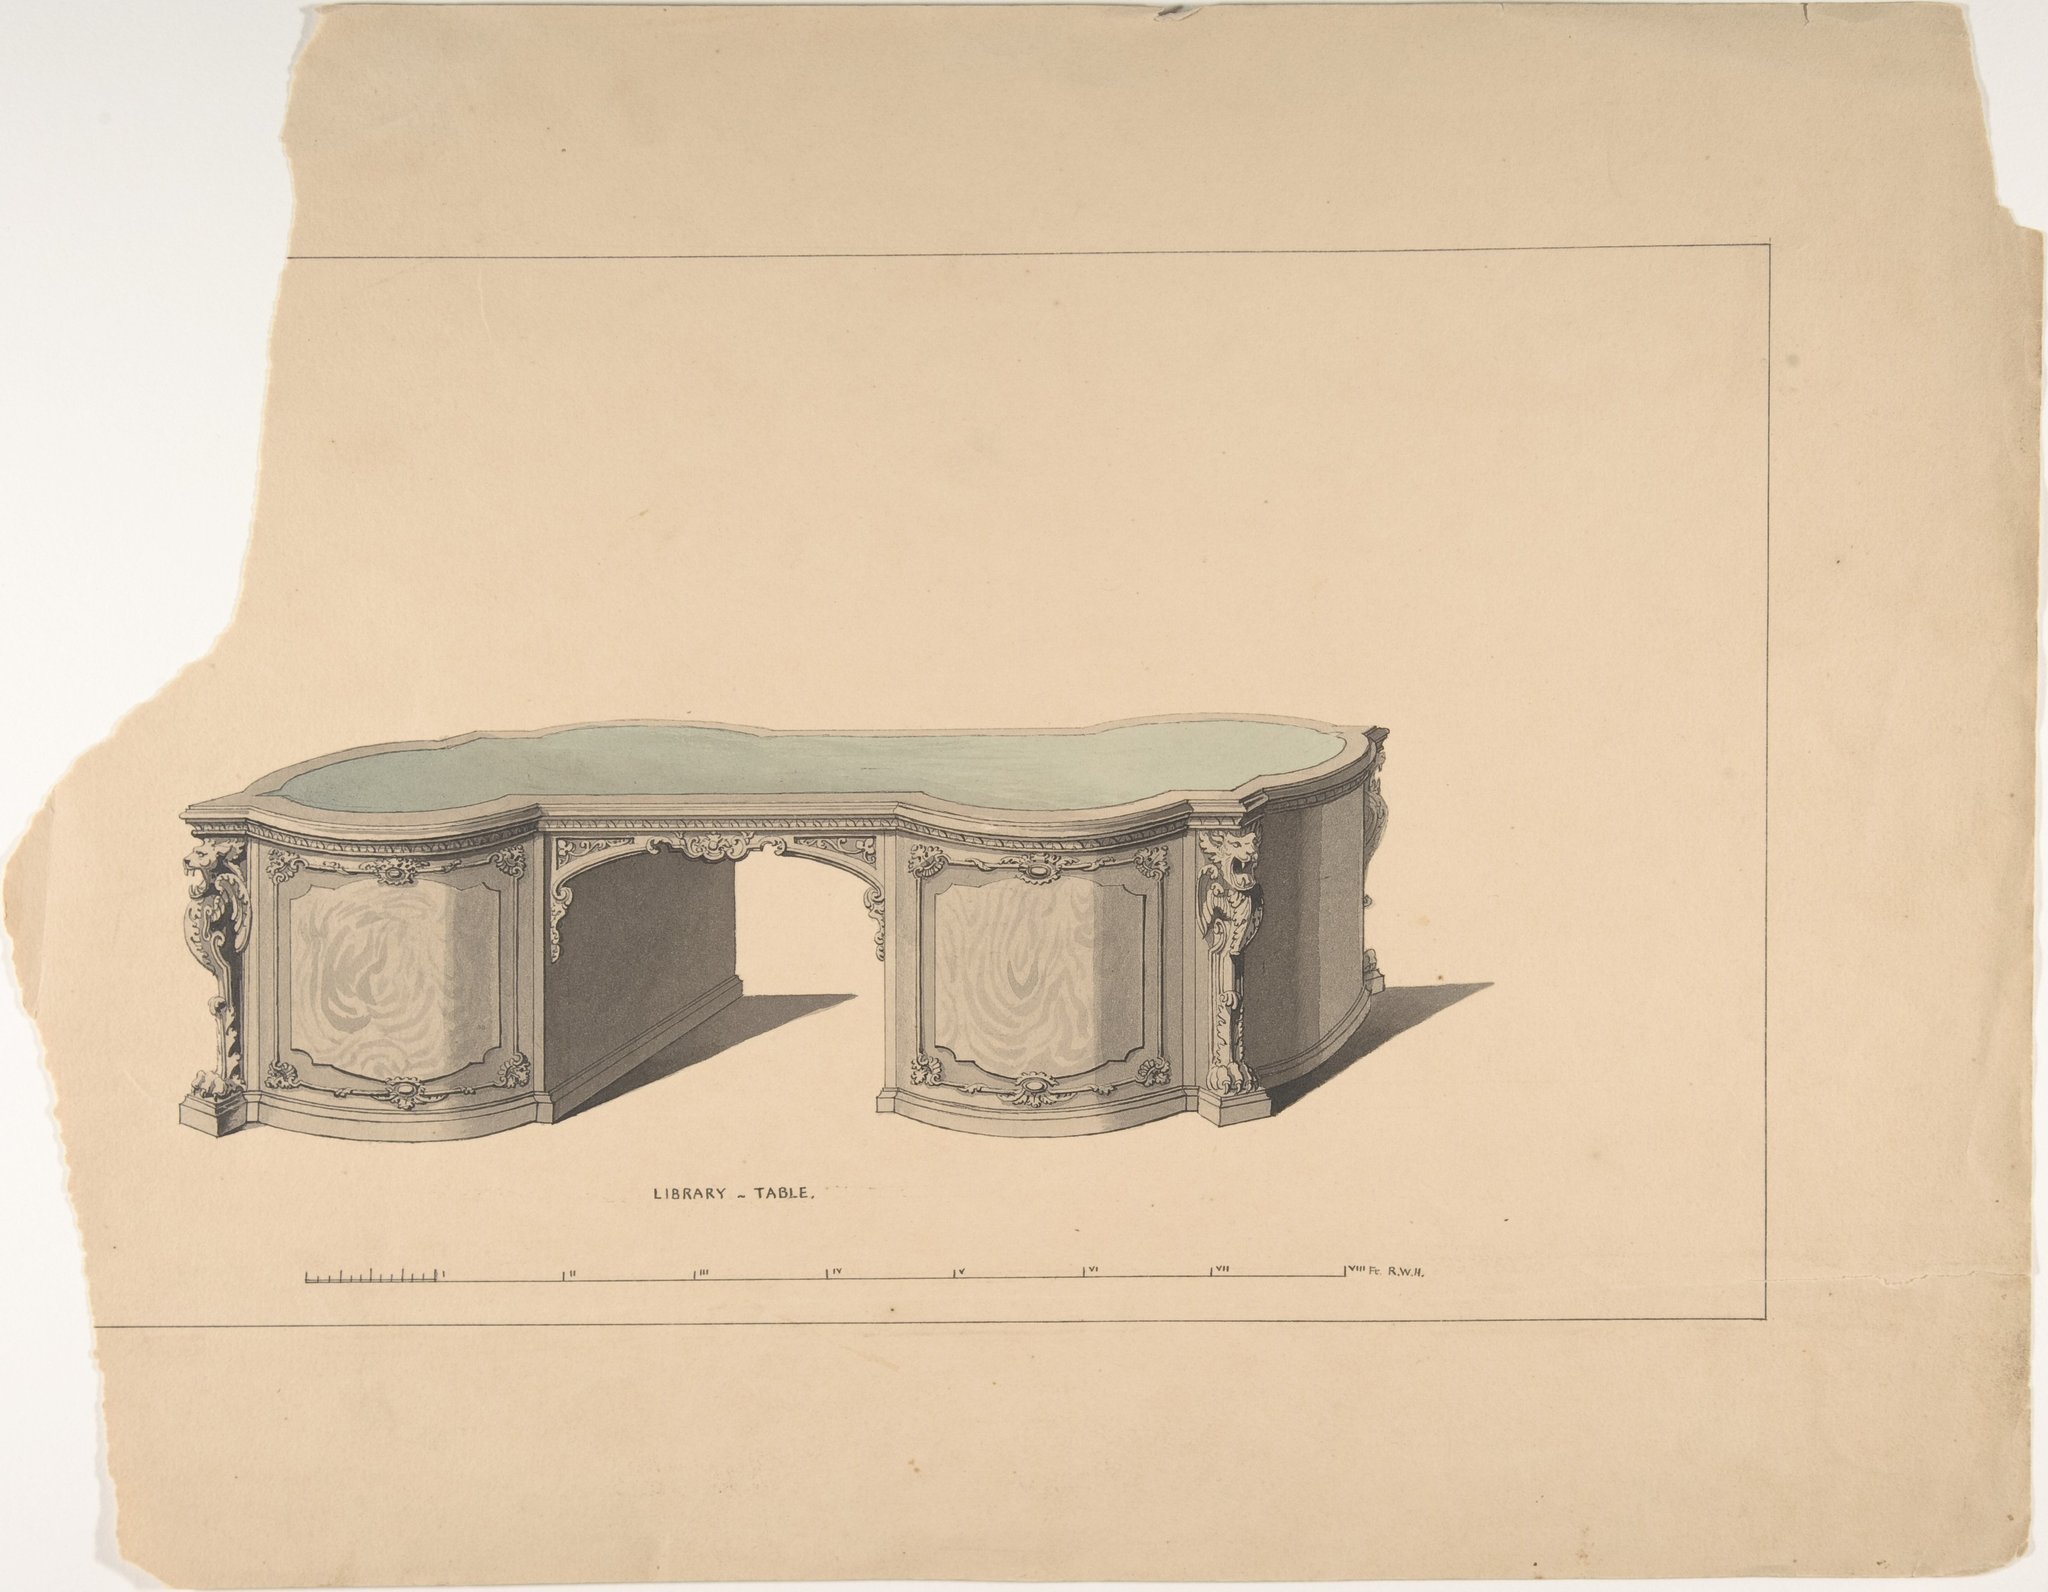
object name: drawing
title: Design for Library Table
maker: robert william hume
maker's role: artist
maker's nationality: british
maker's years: 1816-1904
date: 1835-1900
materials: graphite, ink, watercolor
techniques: pen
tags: tables